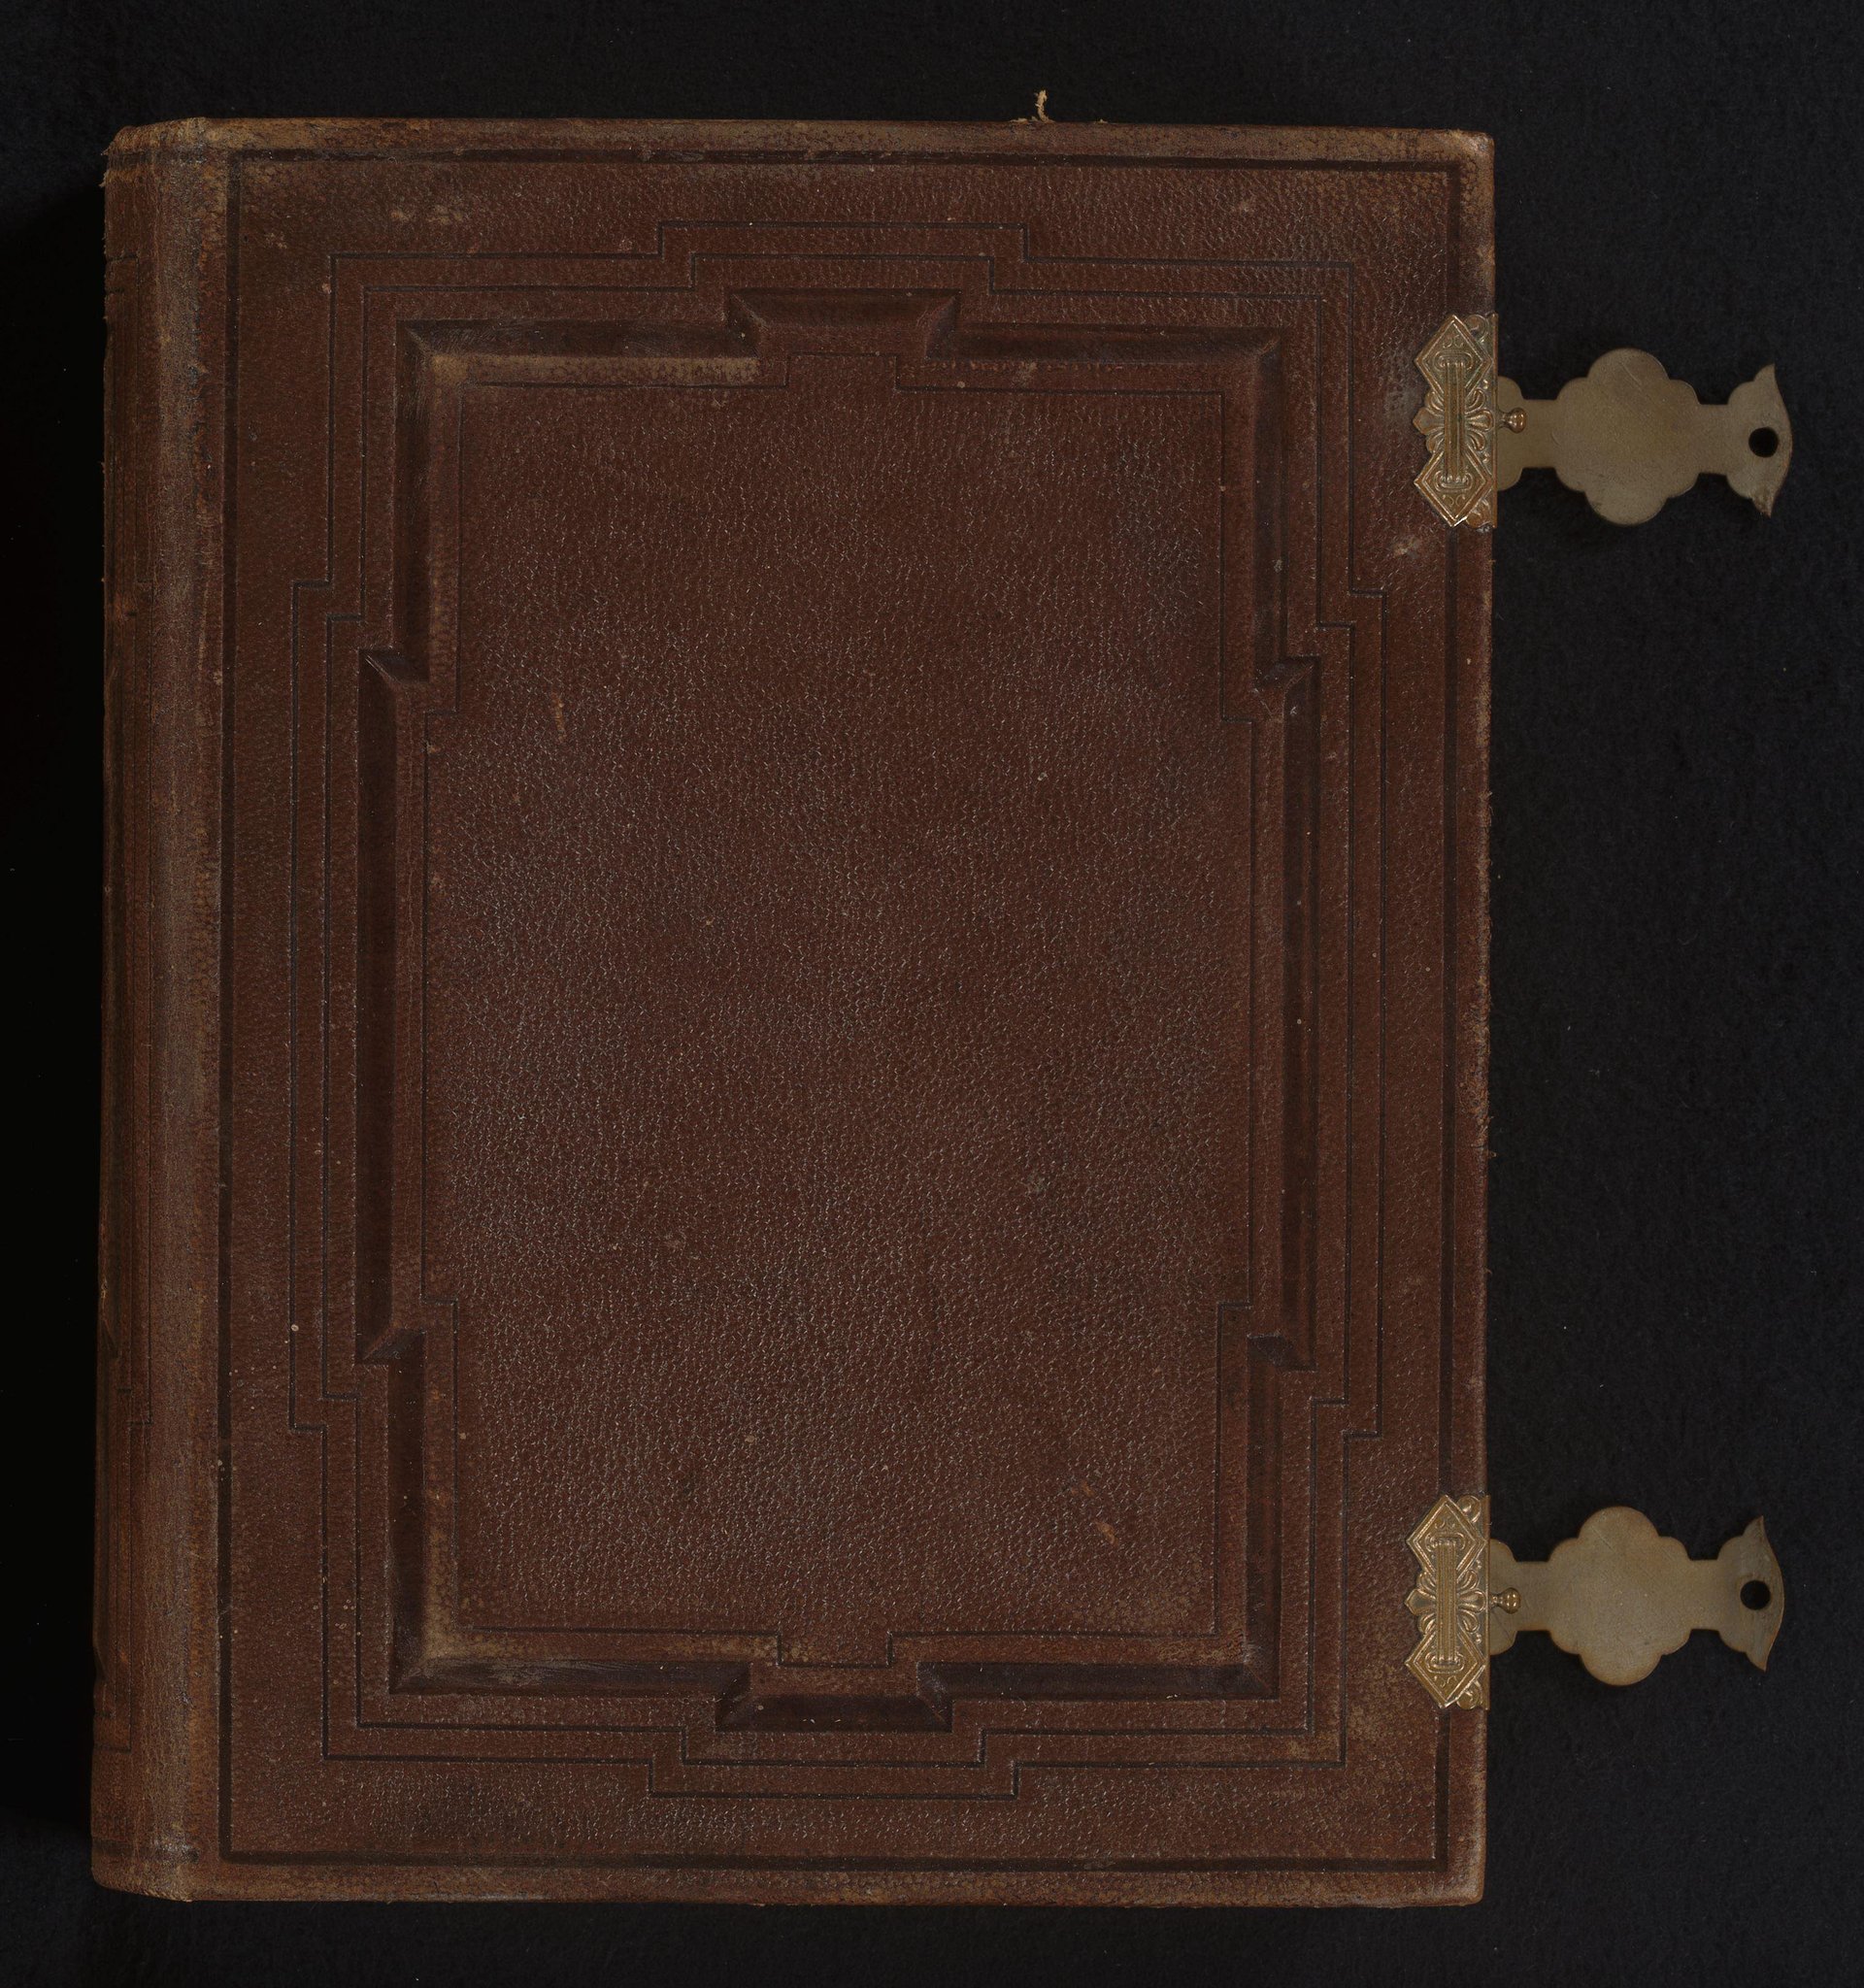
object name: slip in album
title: Fotoalbum (leeg)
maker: Anonymous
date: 1860-1900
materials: cardboard, leather, metal, paper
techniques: color on snow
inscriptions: collector's mark: ‘DIENST/ VERSPREIDE/ RIJKSKOLLEKTIES/ (...) A 855’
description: Fotoalbum met dertig pagina's met ieder een met gepreegde rand omkaderde passe-partout voor een kabinetfoto. Op de rug van het album is de naam Antoine Maitre gepreegd.